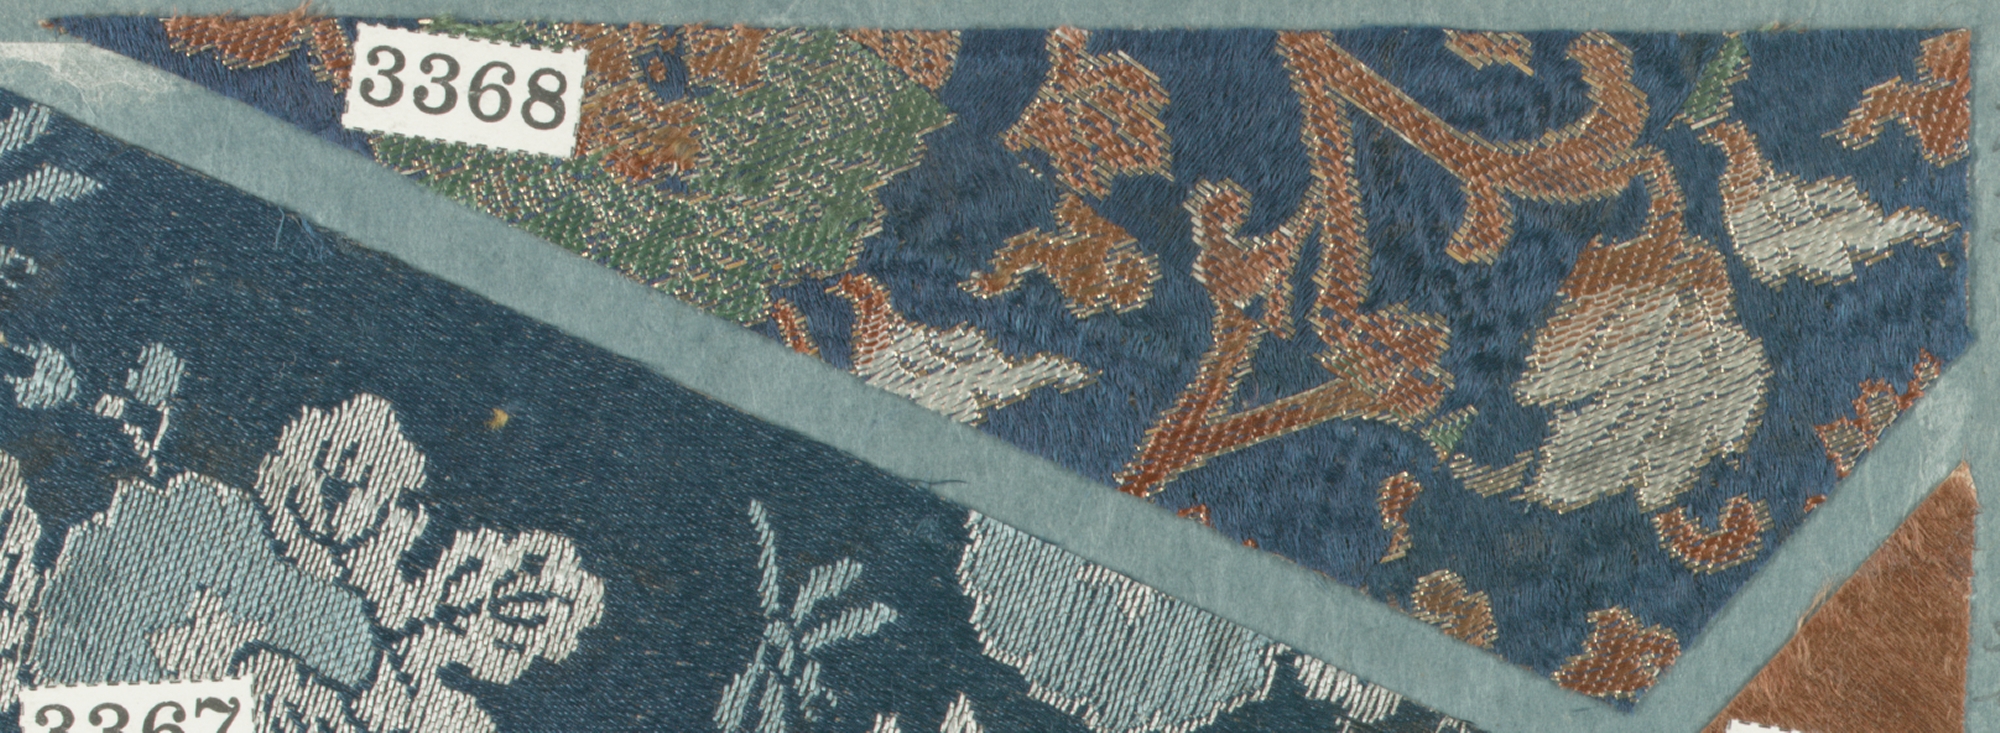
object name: textile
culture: japanese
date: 1801-1900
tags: flowers,leaves